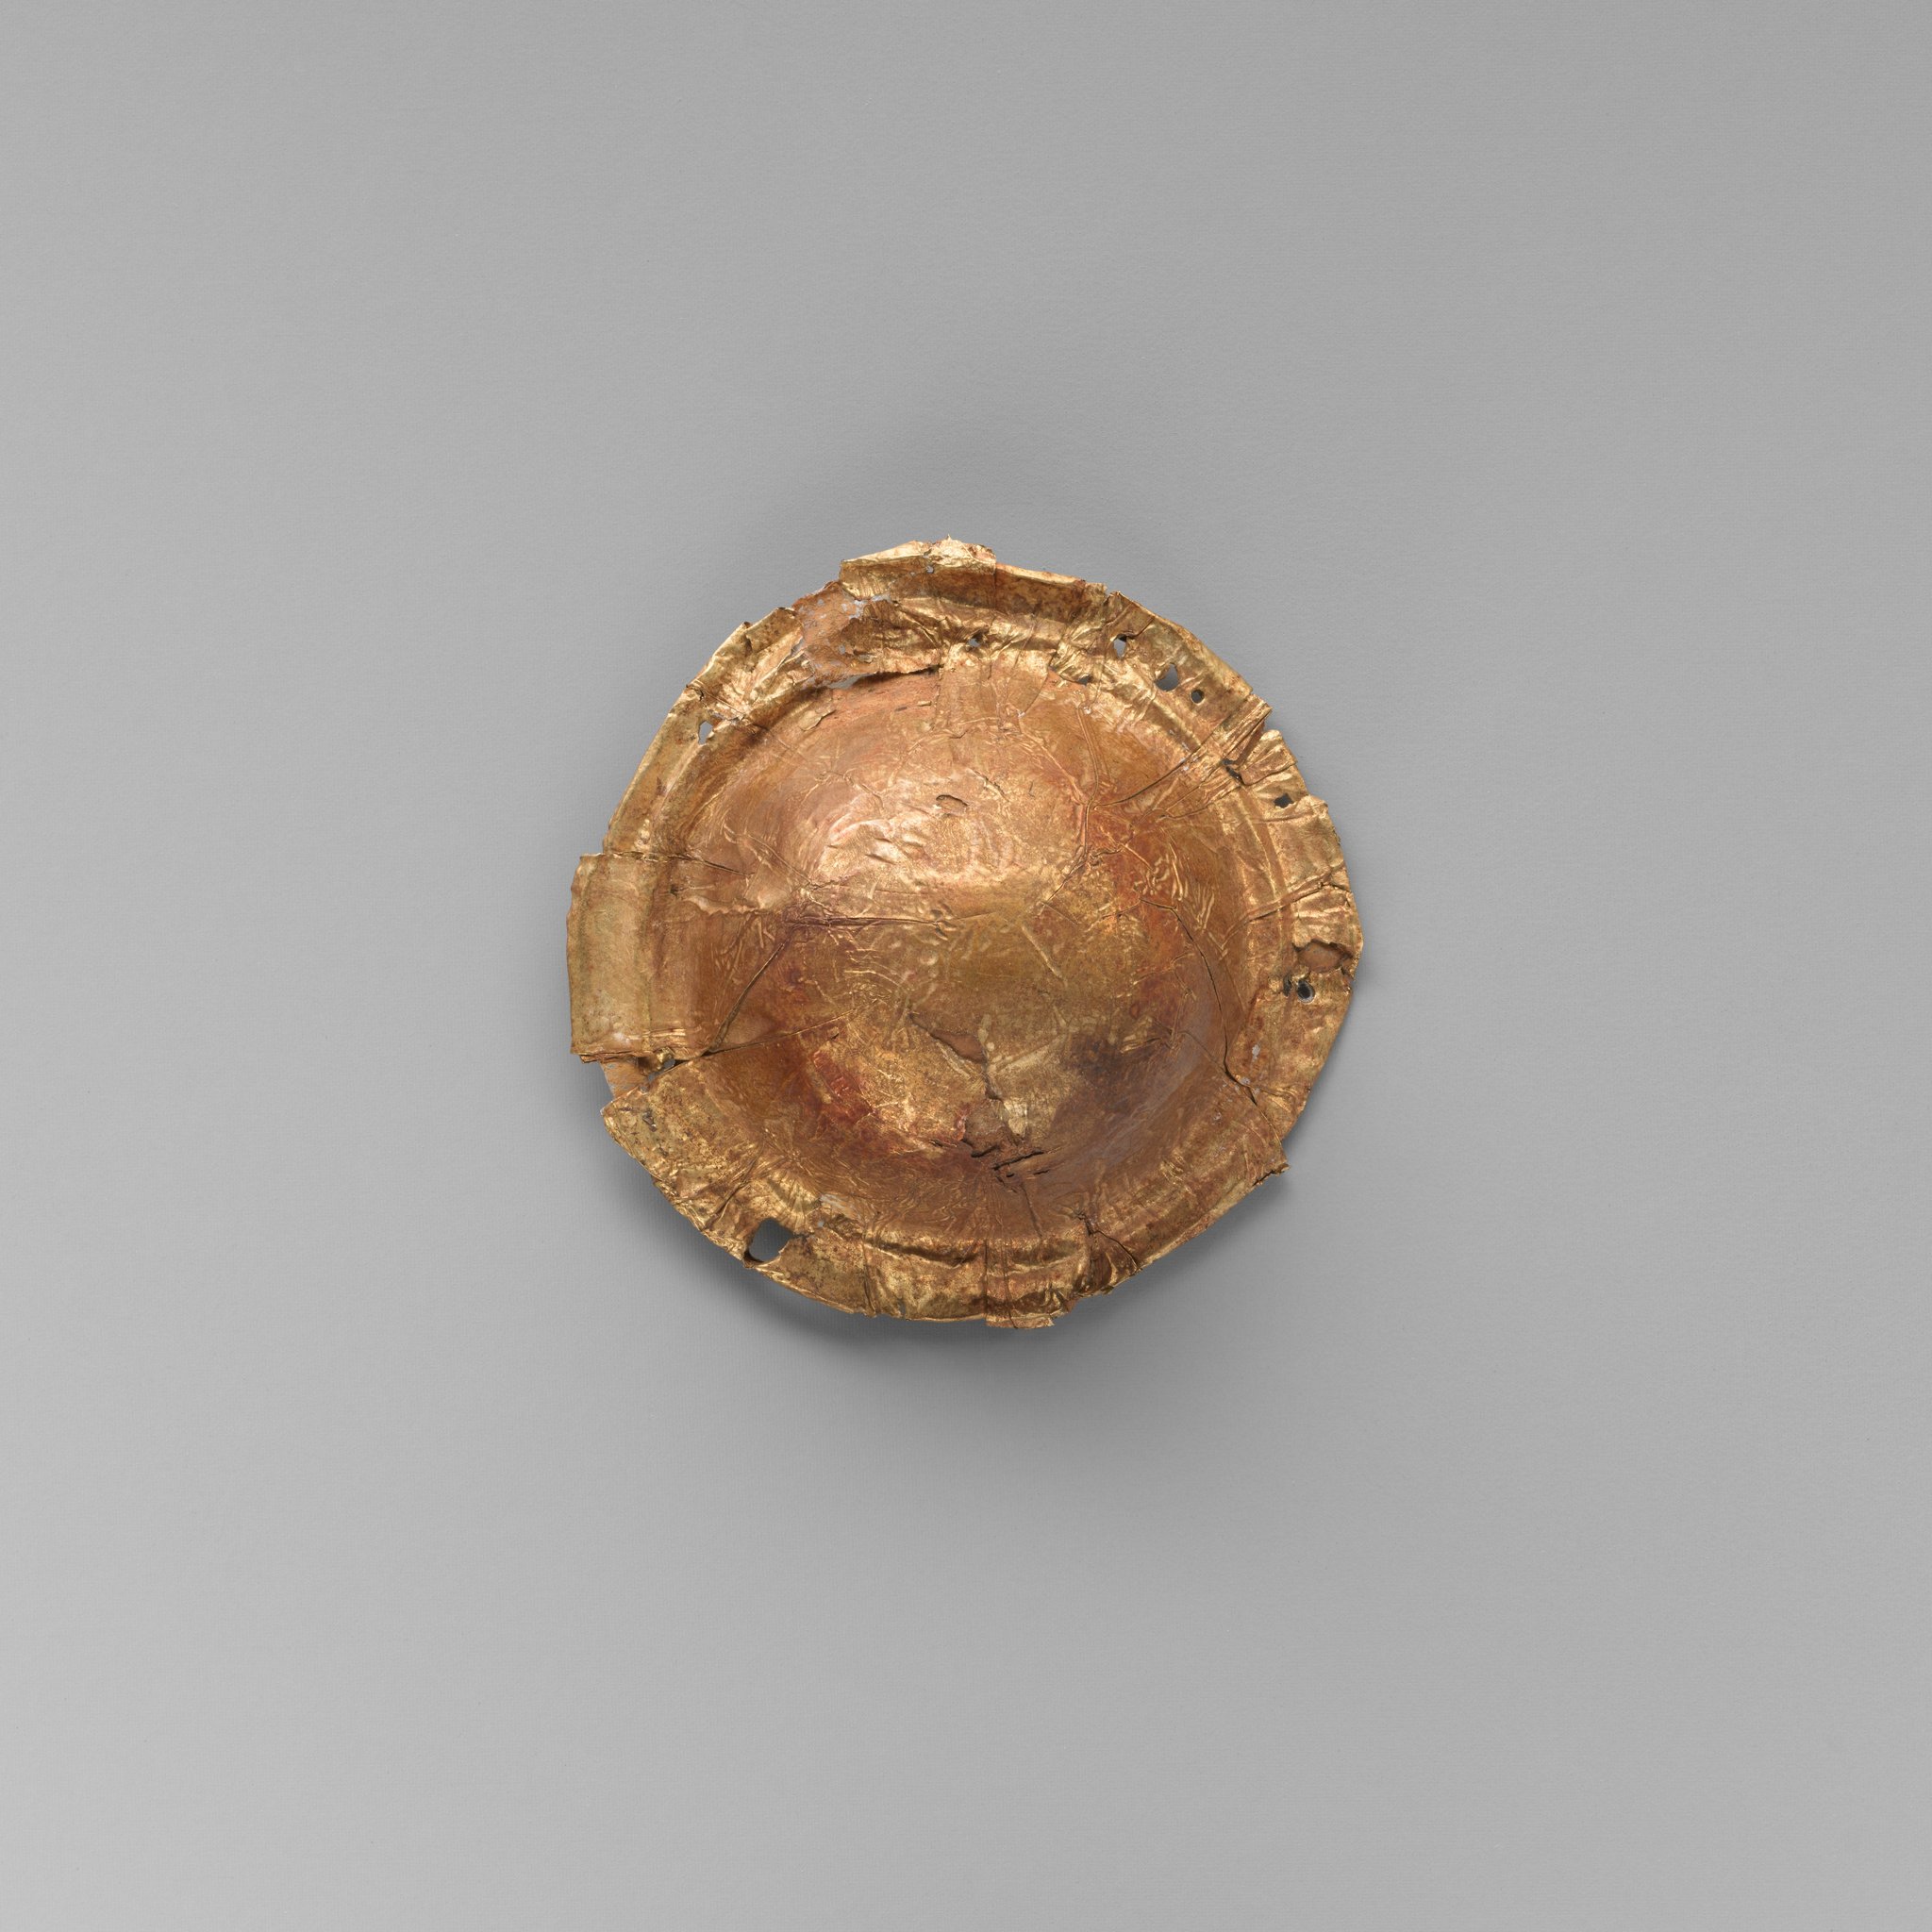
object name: roundel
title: Gold roundel of bulbous form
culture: cypriot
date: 1600-1050 BCE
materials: gold